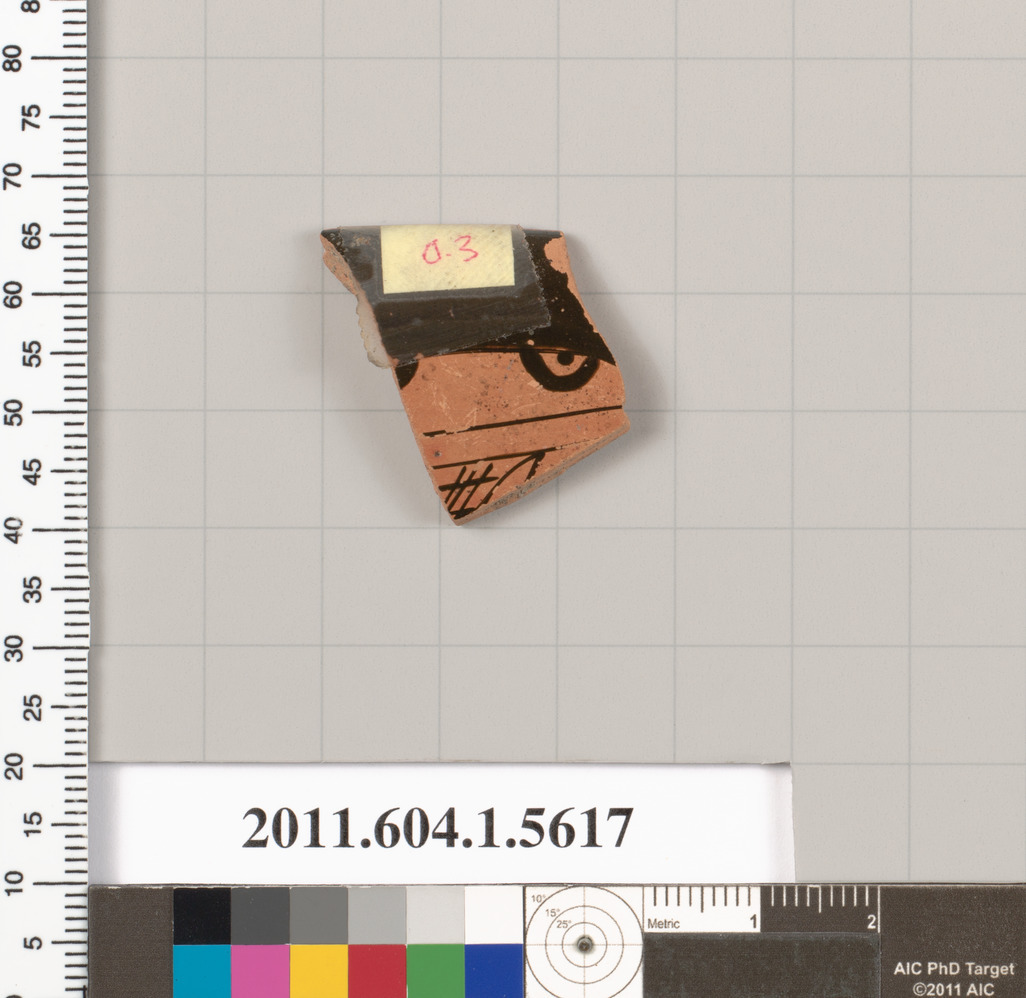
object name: kylix fragment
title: Terracotta rim fragment of a kylix (drinking cup)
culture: greek, attic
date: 510-490 BCE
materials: terracotta